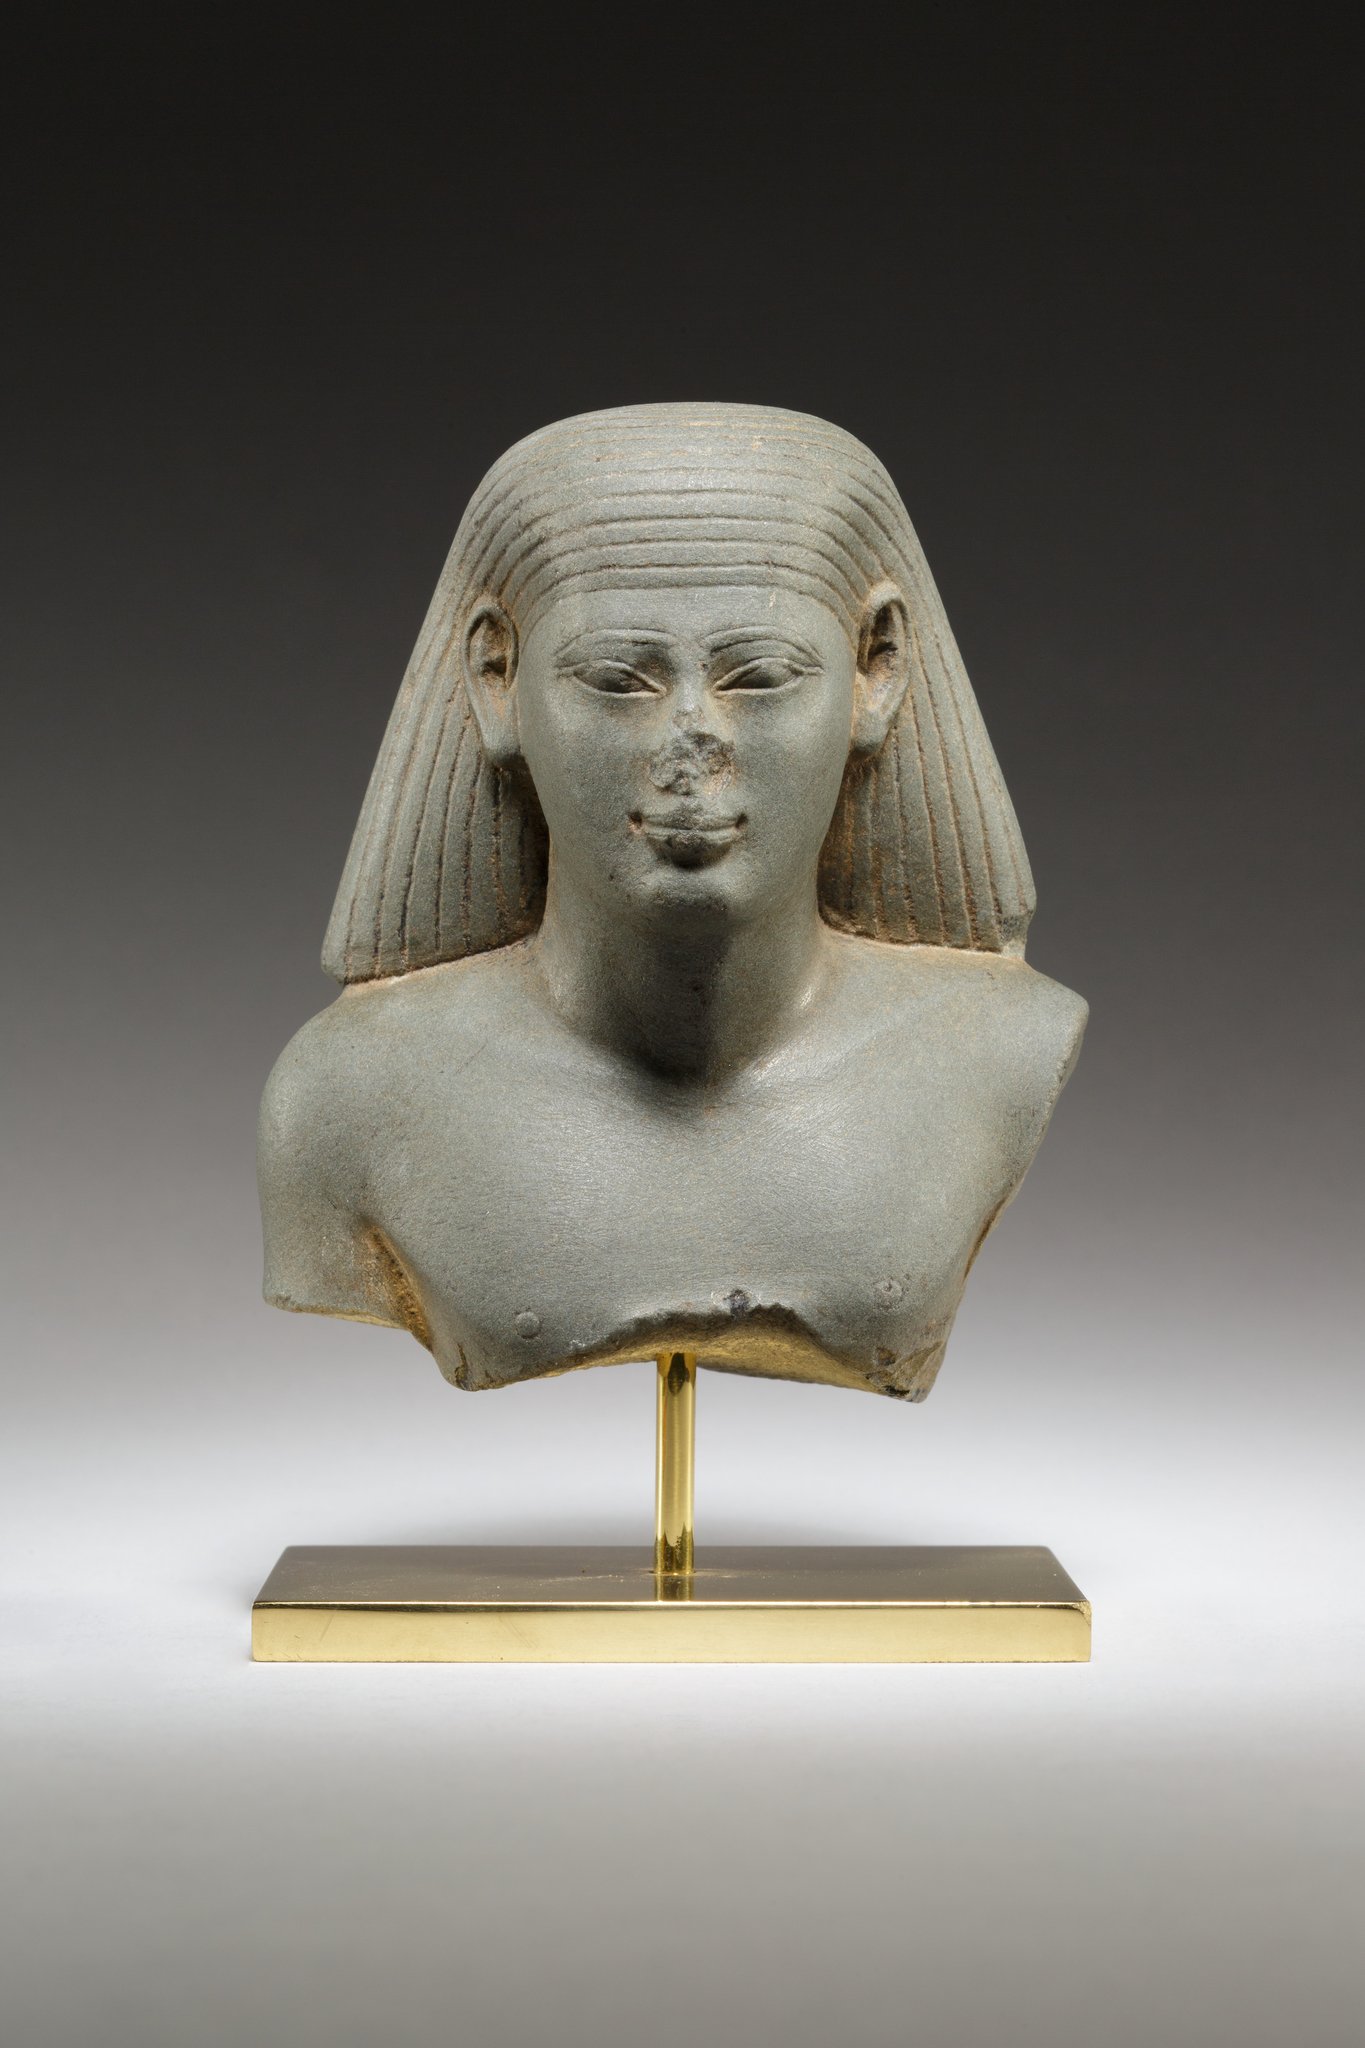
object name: bust, private person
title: Bust of an Administrator of the Domain of Neit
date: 600 BCE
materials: stone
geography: egypt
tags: men,hieroglyphs